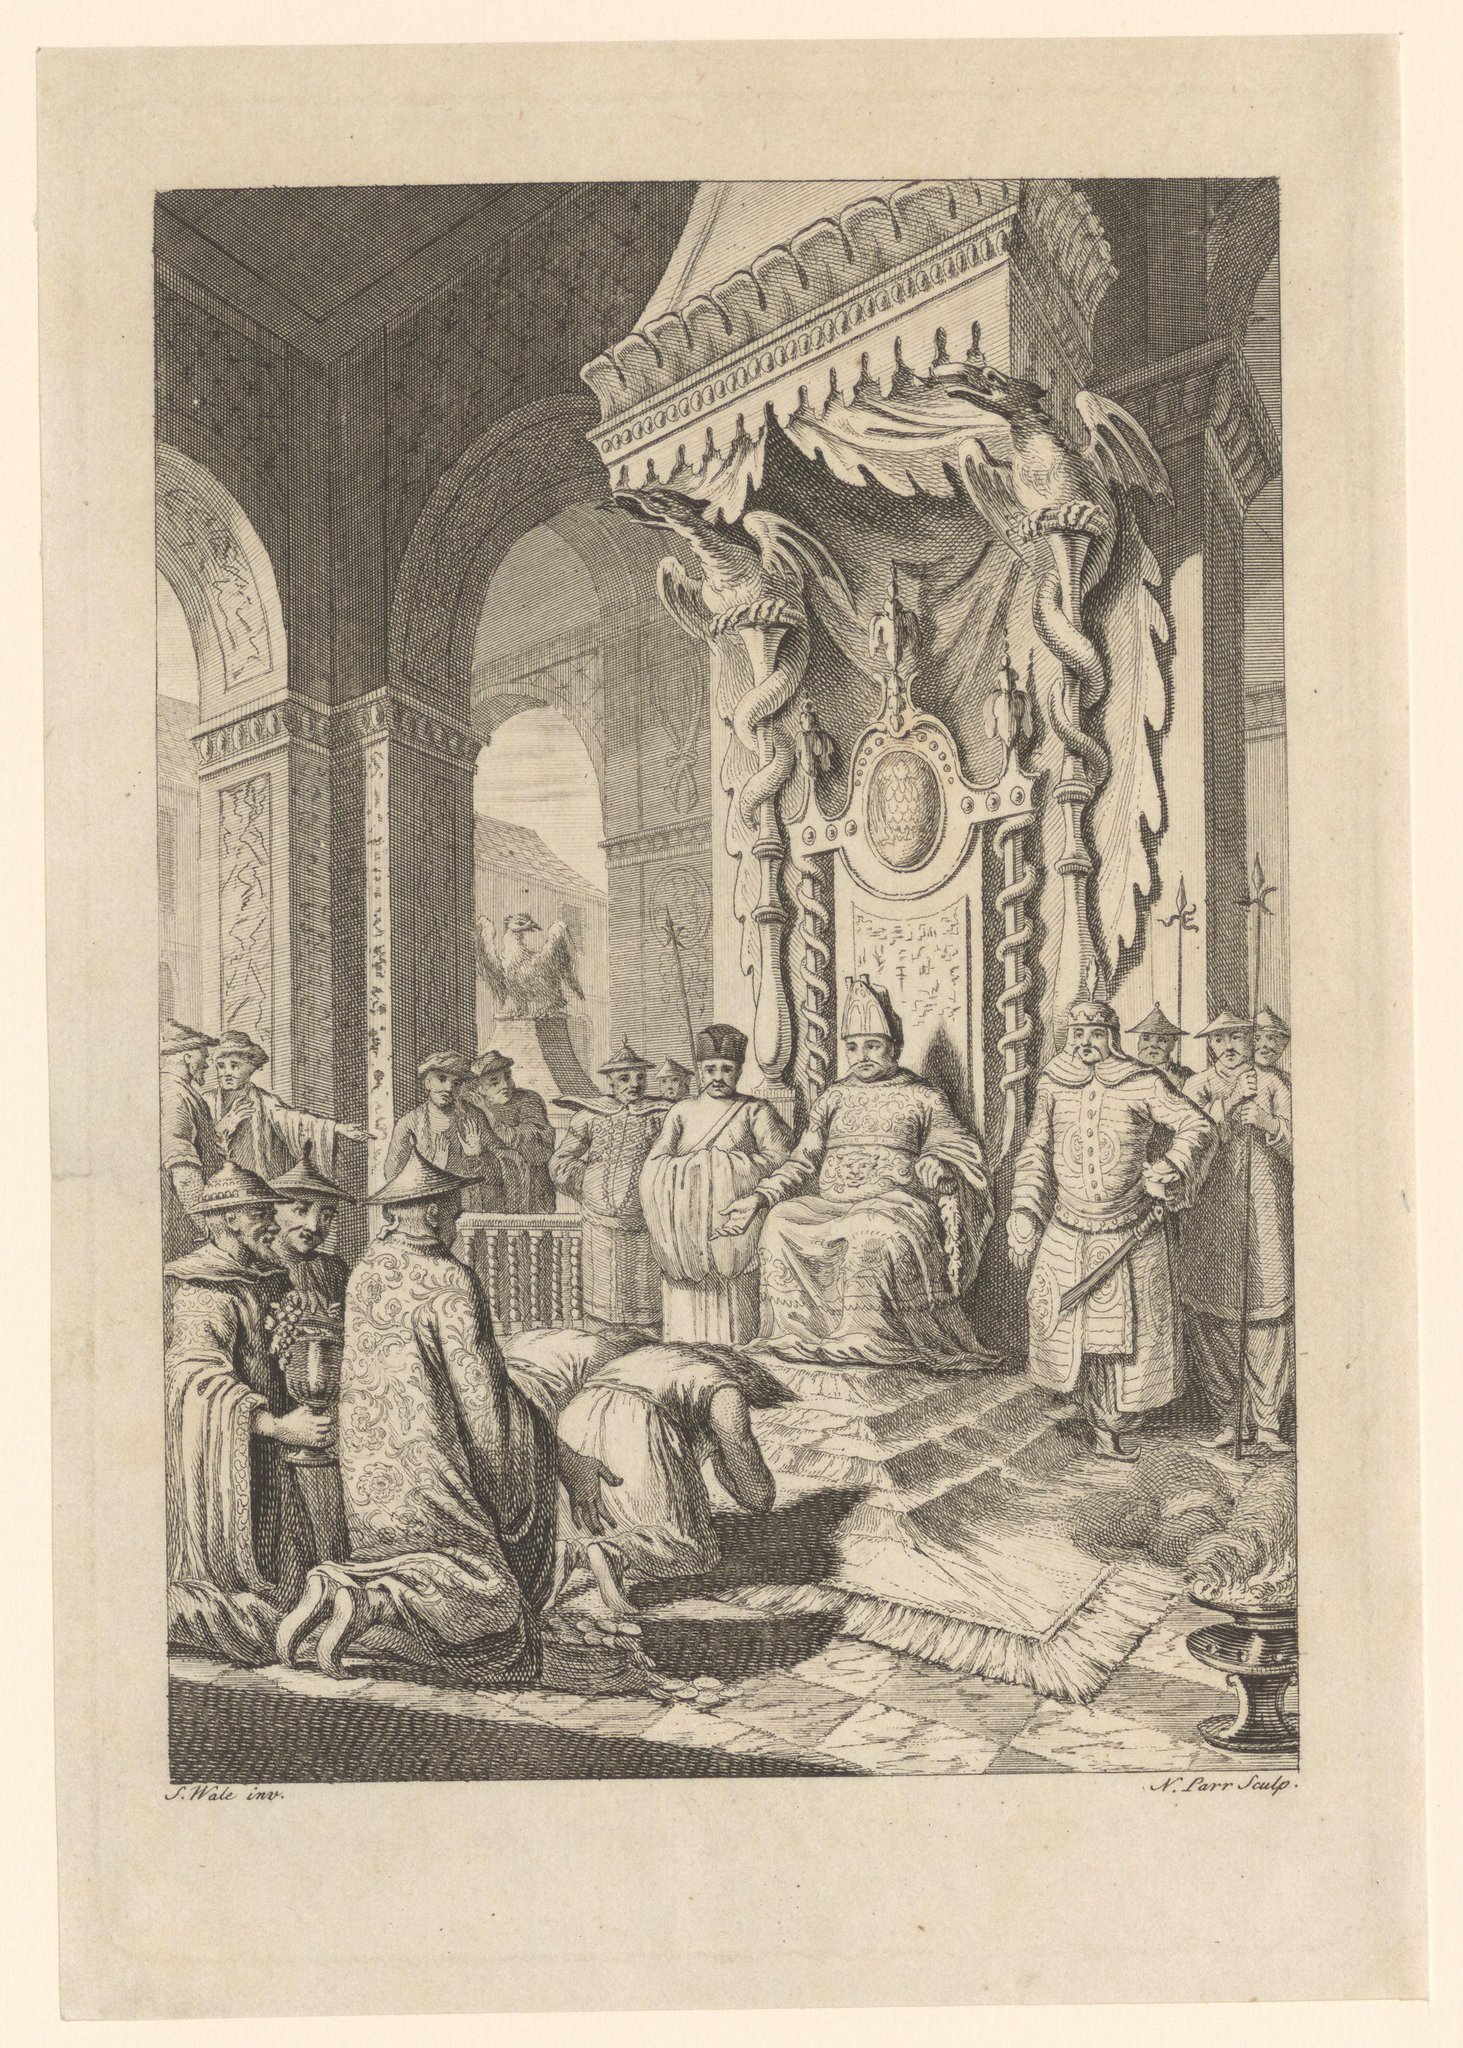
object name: print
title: Aziatische keizer op troon ontvangt een delegatie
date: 1739-1767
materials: paper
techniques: etching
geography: london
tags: throne, emperor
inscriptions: collector's mark: Lugt 2228